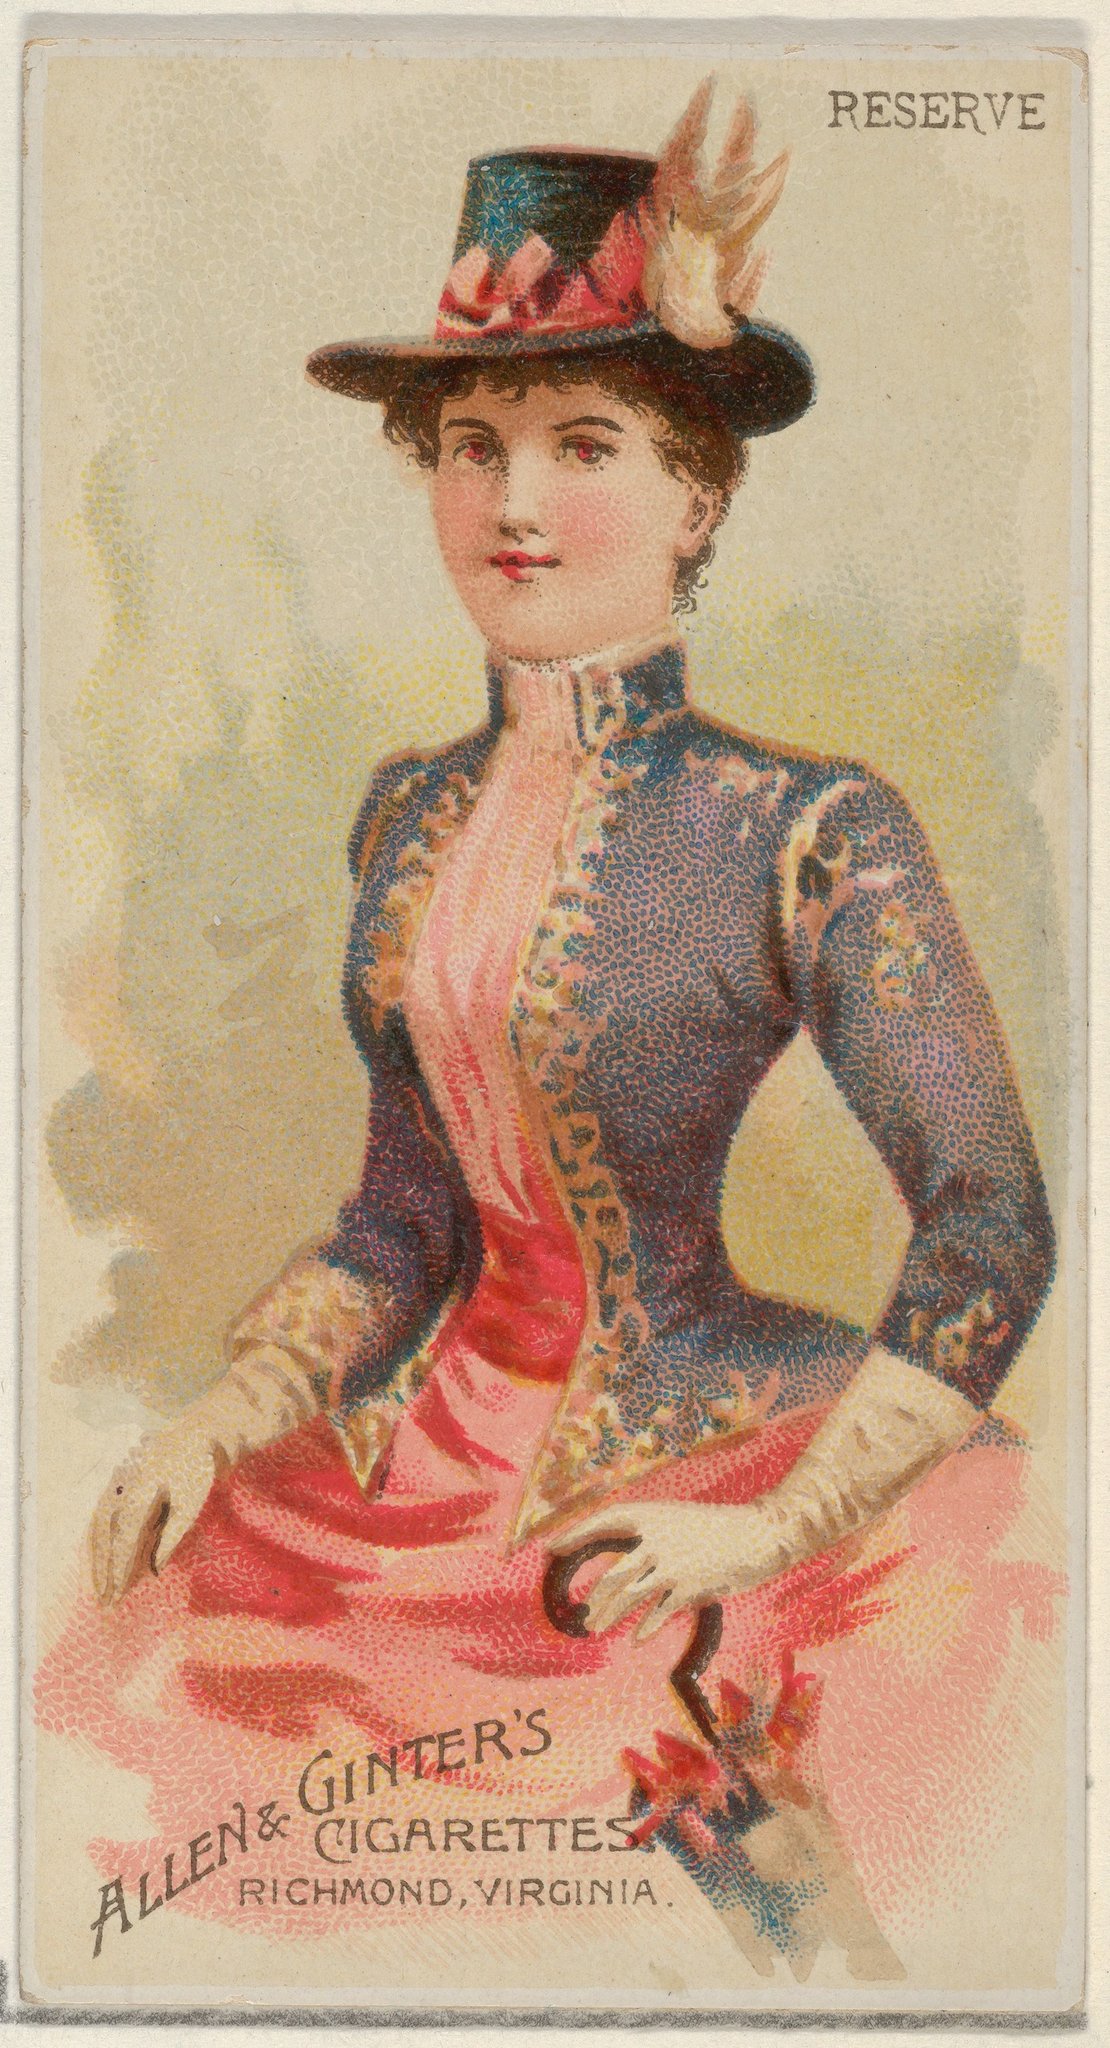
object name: print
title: Reserve, from the Parasol Drills series (N18) for Allen & Ginter Cigarettes Brands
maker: allen & ginter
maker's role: publisher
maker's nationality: american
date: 1888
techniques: color lithograph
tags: women